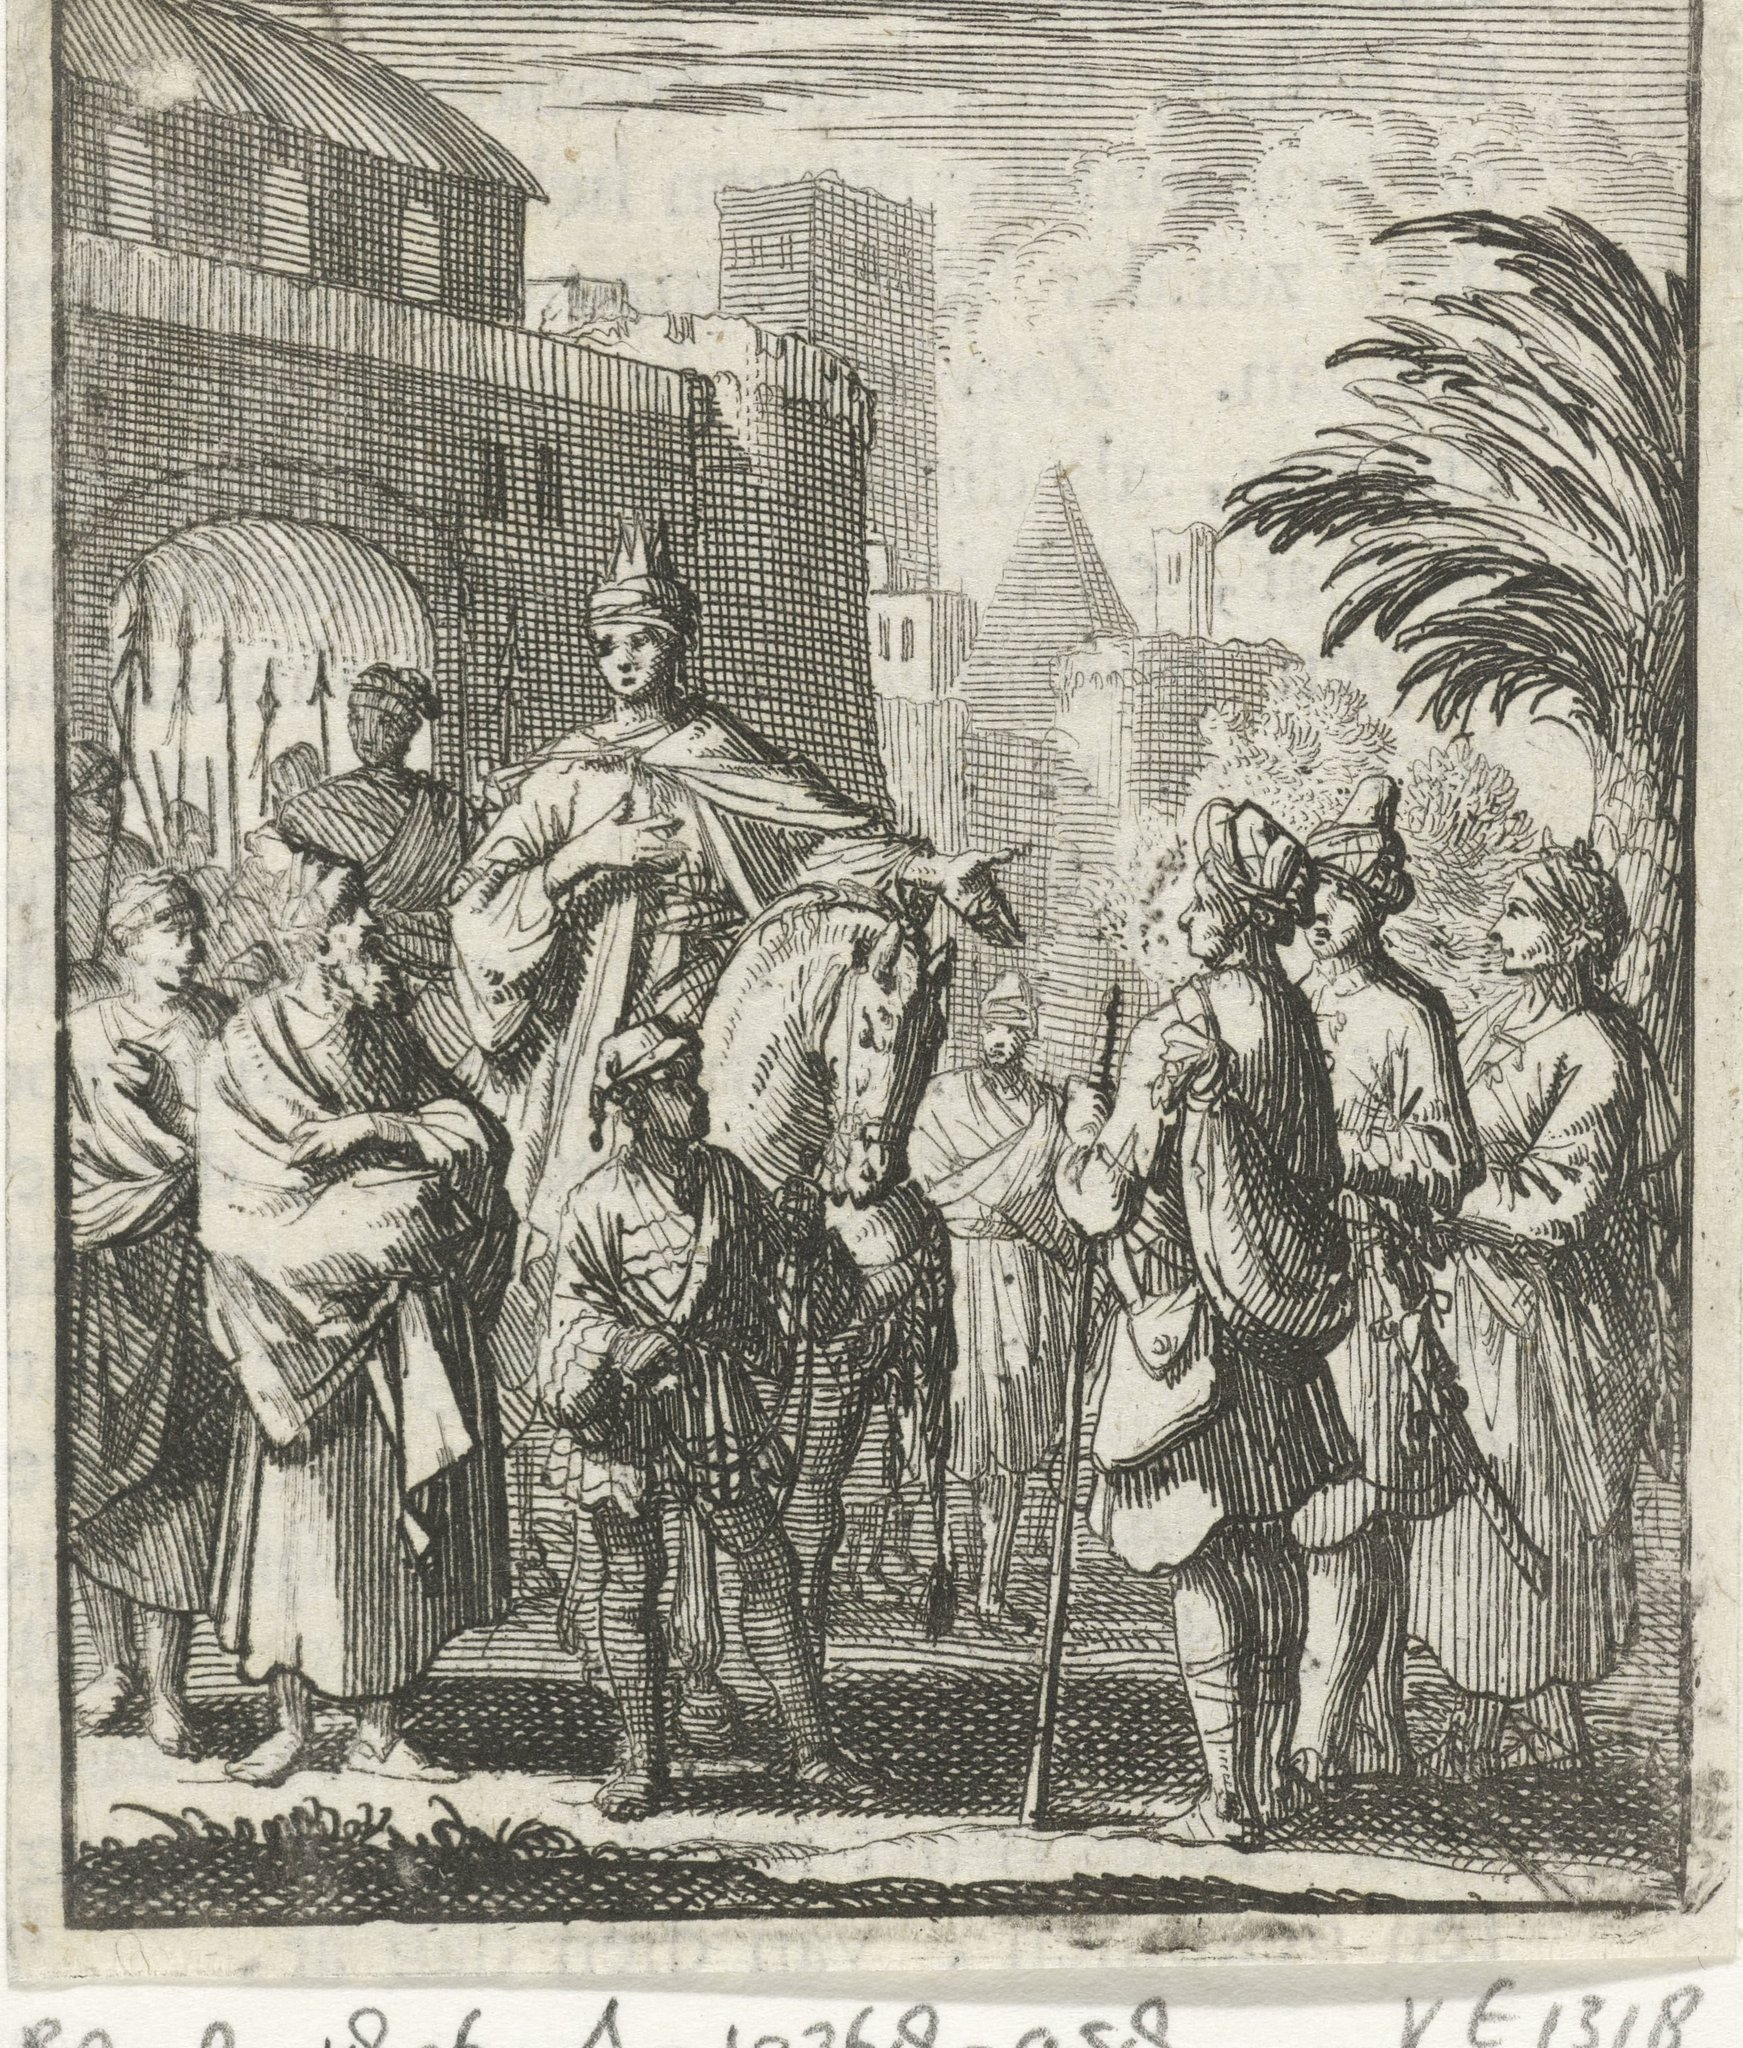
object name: print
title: Vreemdeling, tot koning benoemd, wordt te paard naar de stadspoort geleid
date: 1693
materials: paper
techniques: etching, letterpress printing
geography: amsterdam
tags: city-gate, king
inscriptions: collector's mark: Lugt 2228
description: Illustratie uit: Duĳkerius, Johannes. Voorbeeldzels der oude wyzen. Waar in (...) de menschelijke hartstogten (...) behandeld worden. Amsterdam: Aart Wolsgrein, 1693, p. 505.